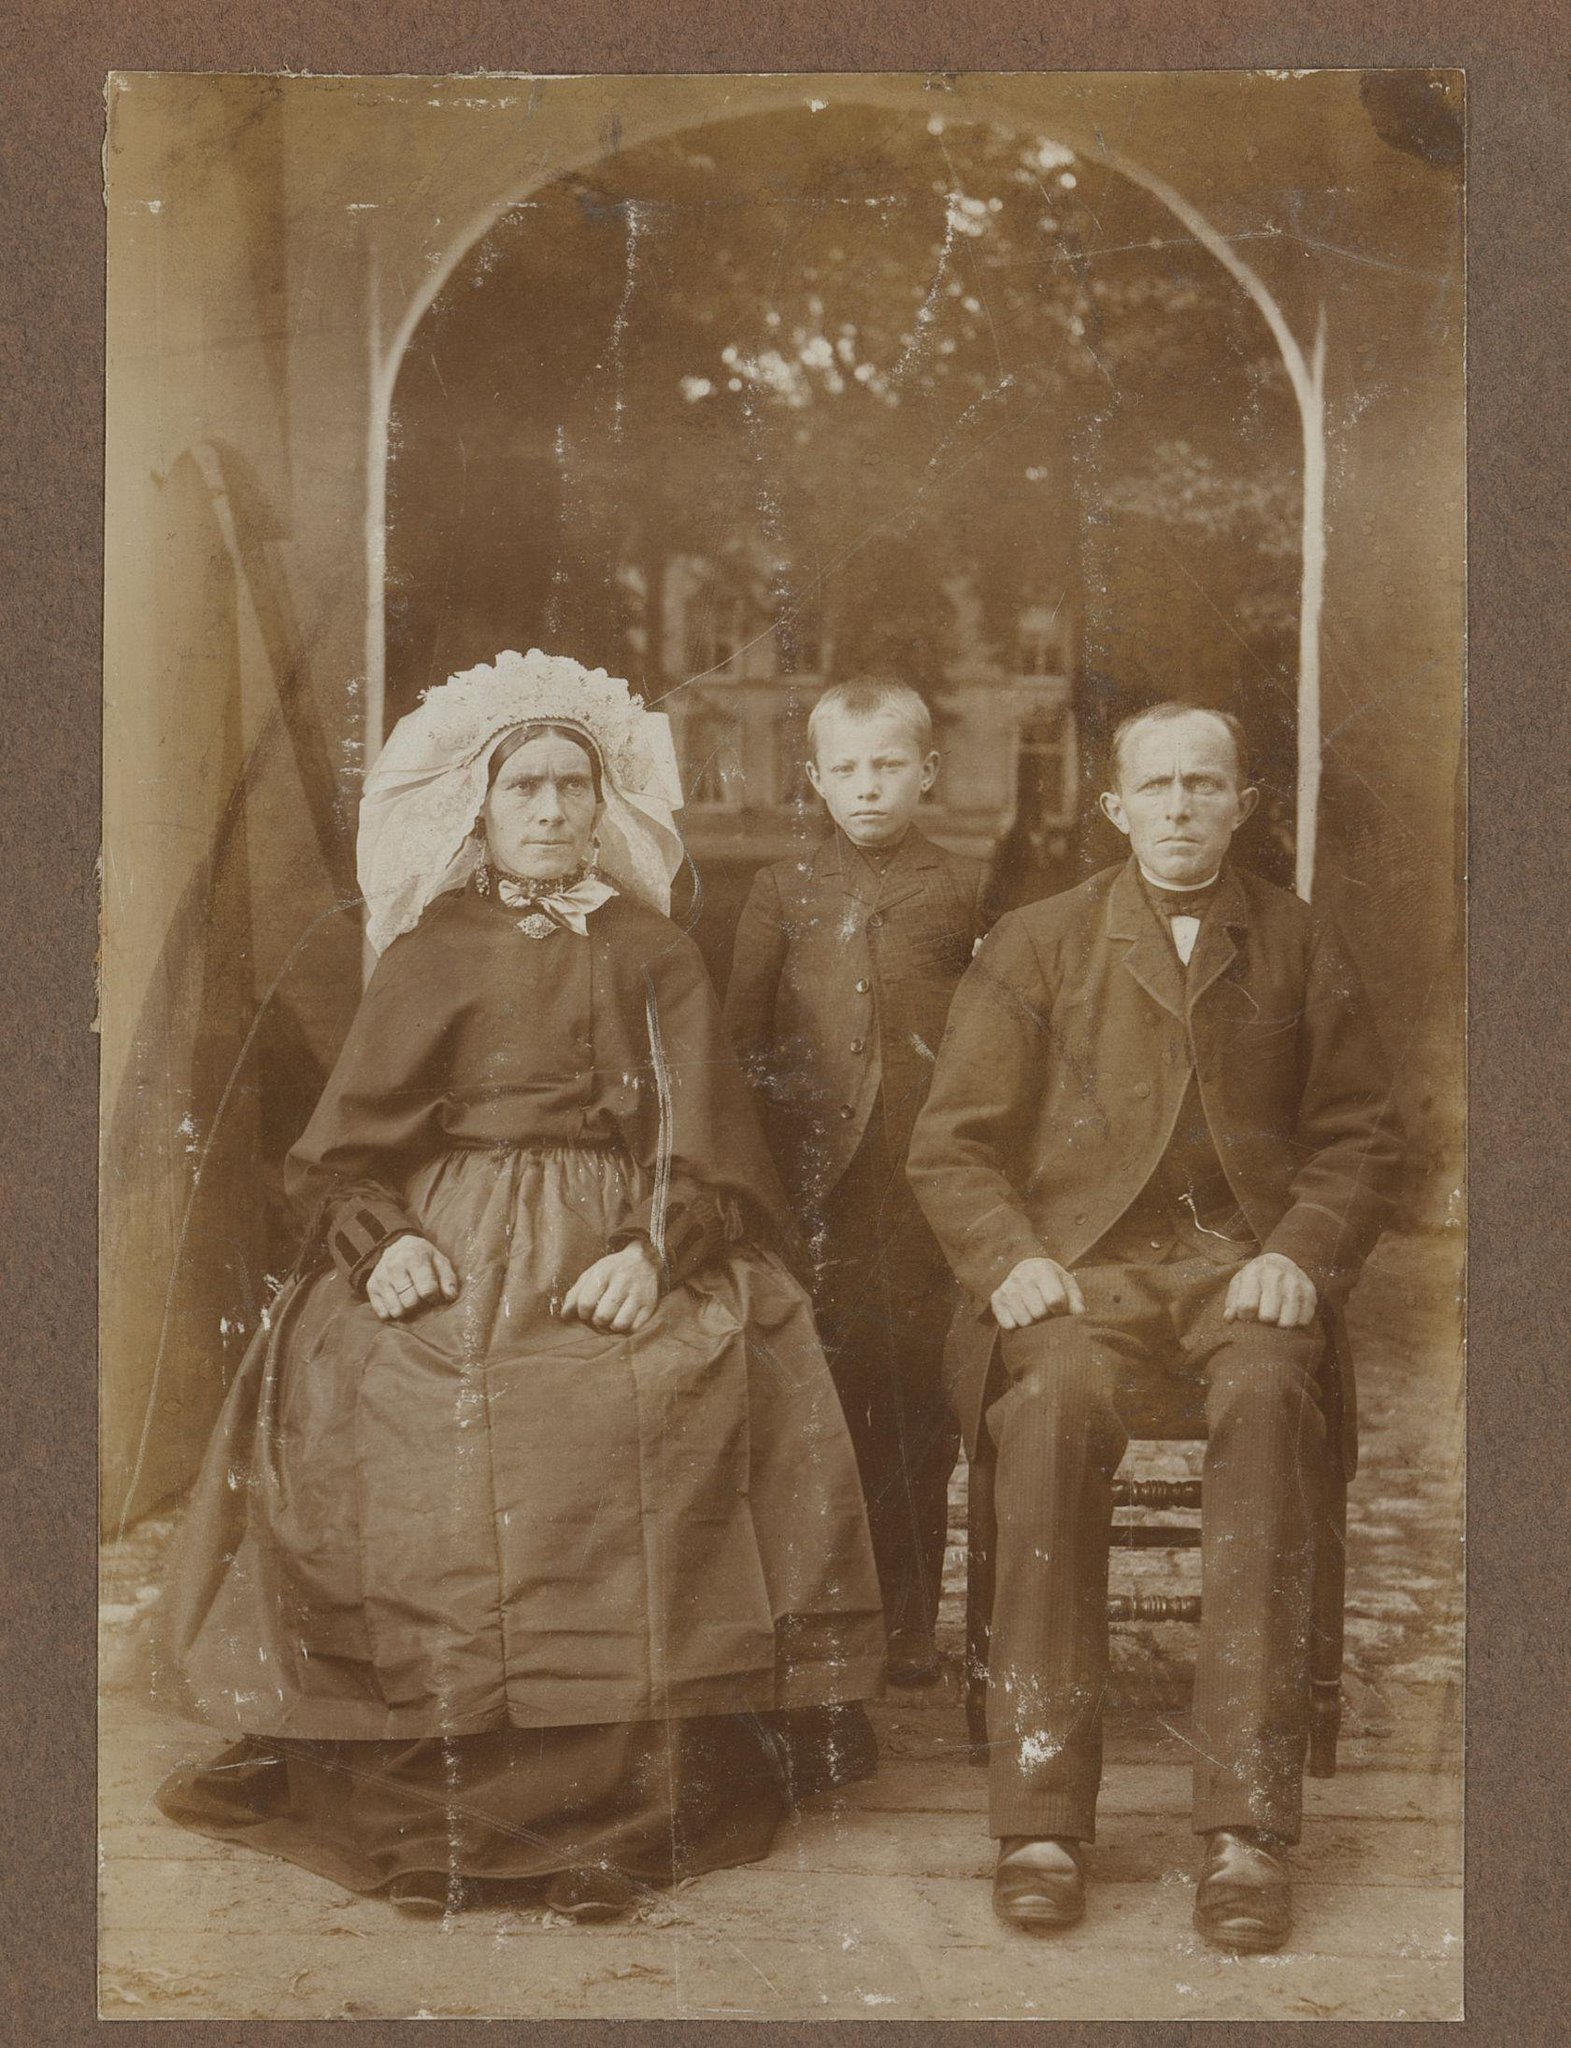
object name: photograph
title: Familie van Leuken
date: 1904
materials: photographic support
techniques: photography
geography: netherlands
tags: beek en donk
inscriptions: inscription: ‘Familie van Leuken / Beek en Donk / 1904.’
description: Foto op bruin albumblad 23 van familiealbum van Alphons Diepenbrock.